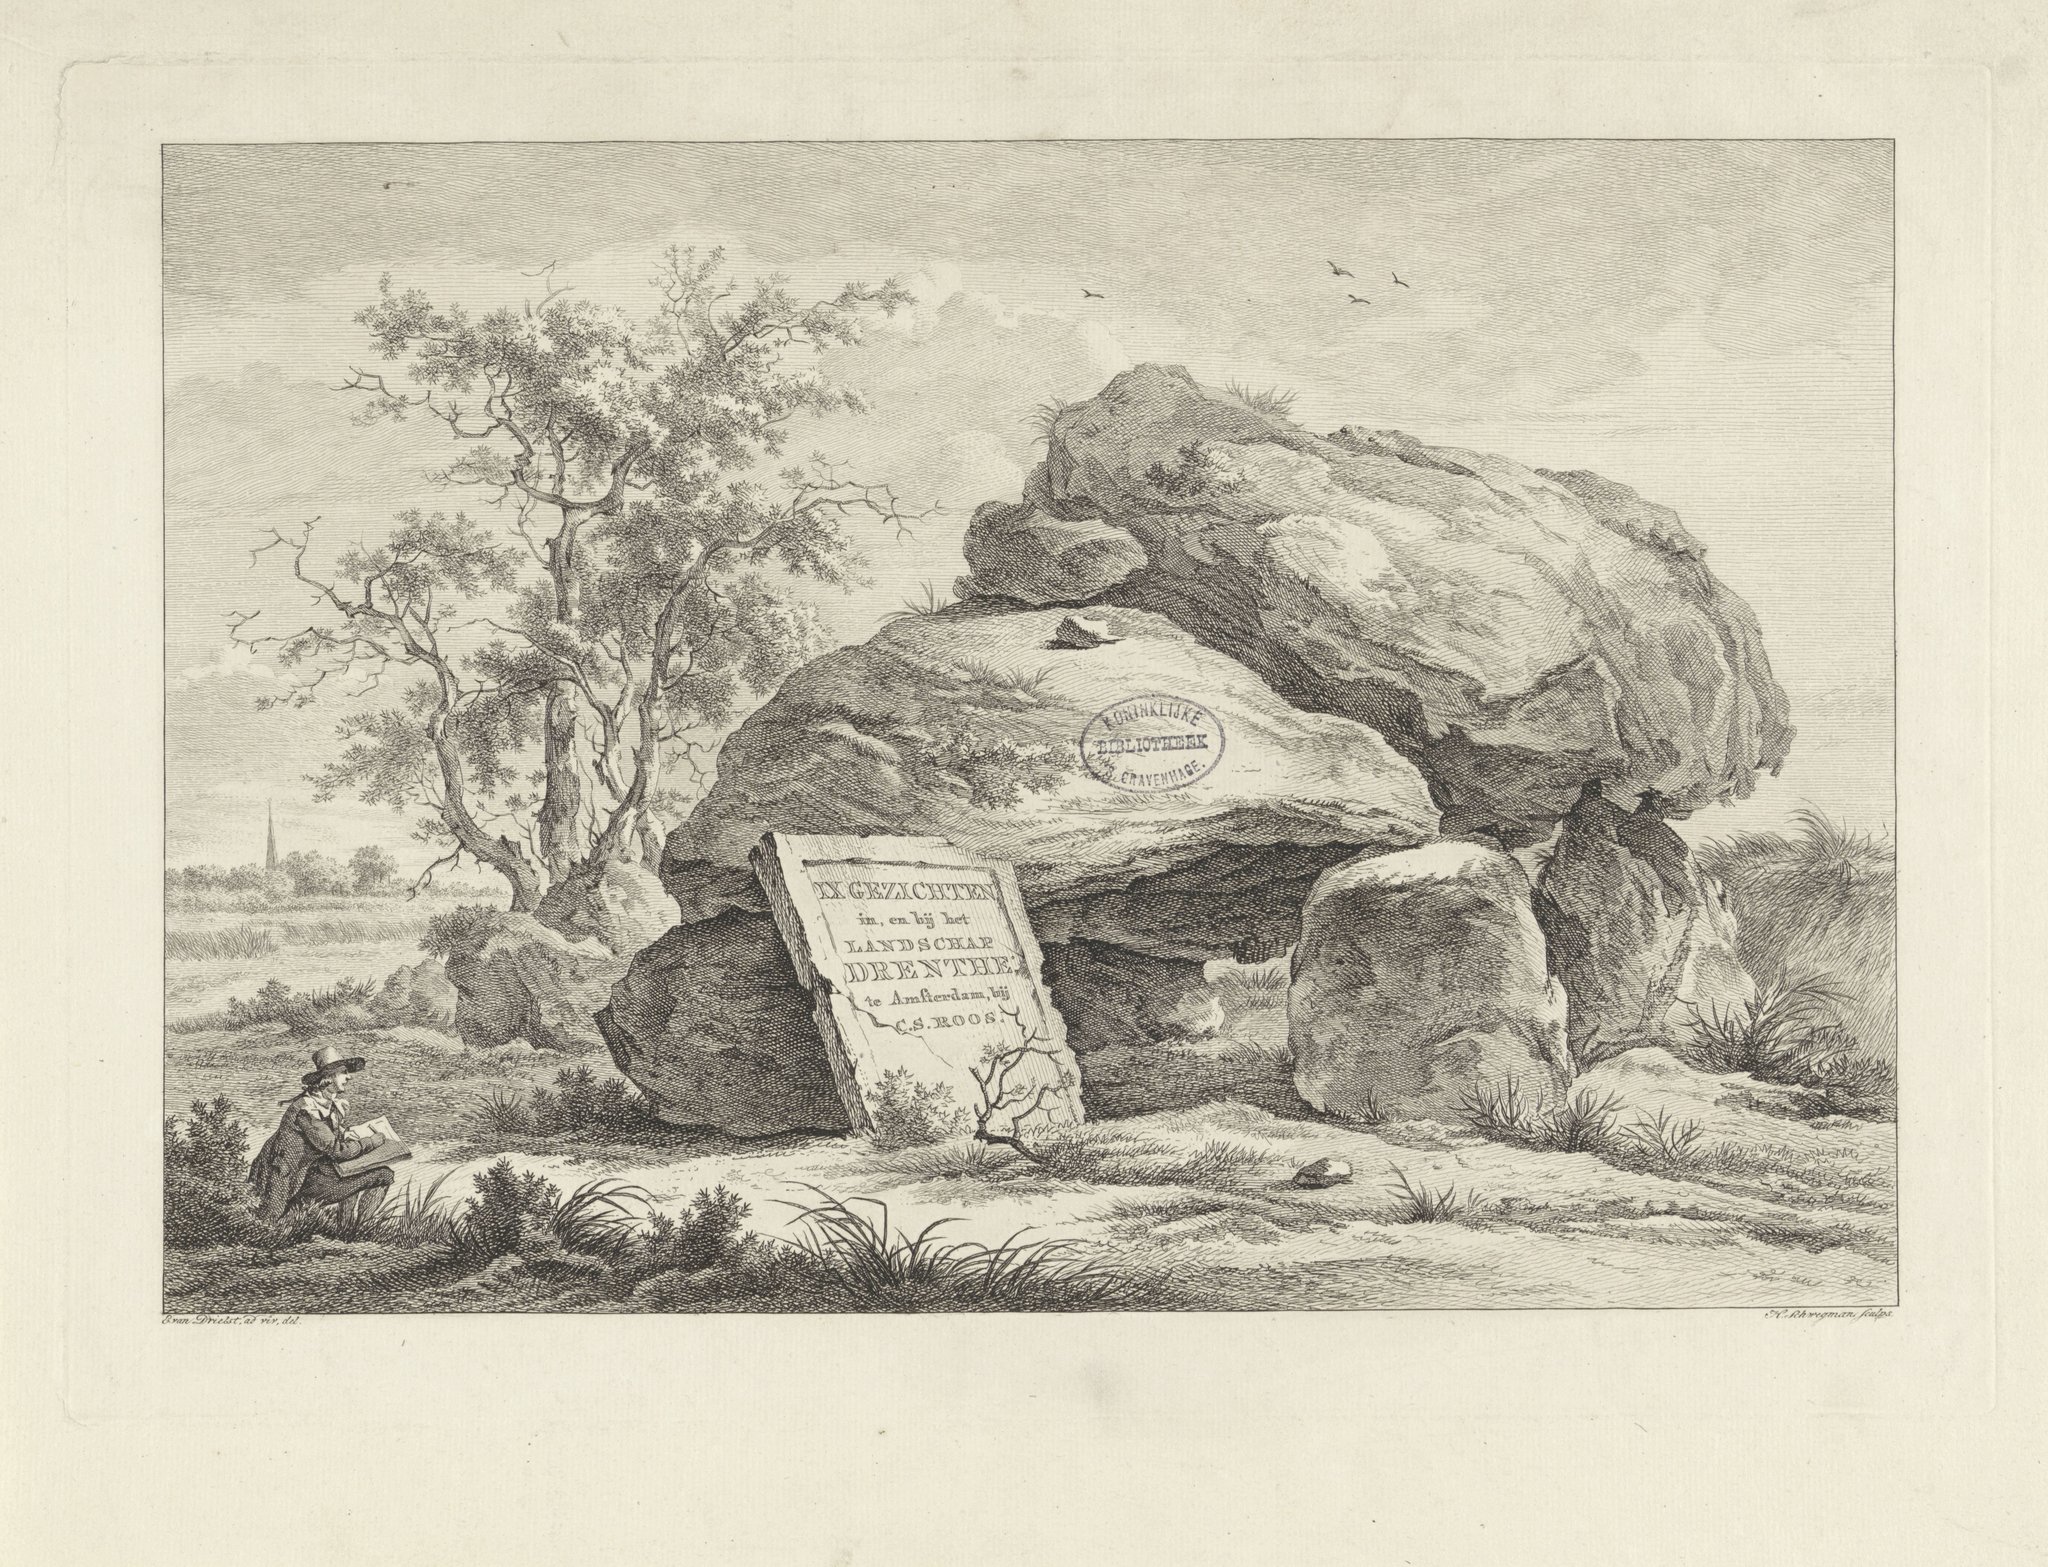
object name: print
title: IX Gezichten in en bij het landschap Drenthe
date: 1771-1816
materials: paper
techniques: etching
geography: haarlem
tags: megalithic chambered tomb, dolmen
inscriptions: collector's mark: Lugt 2228, collector's mark: Lugt 1097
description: Hunebed bij het dorp Midlaren in Drenthe. Links zit een tekenaar.